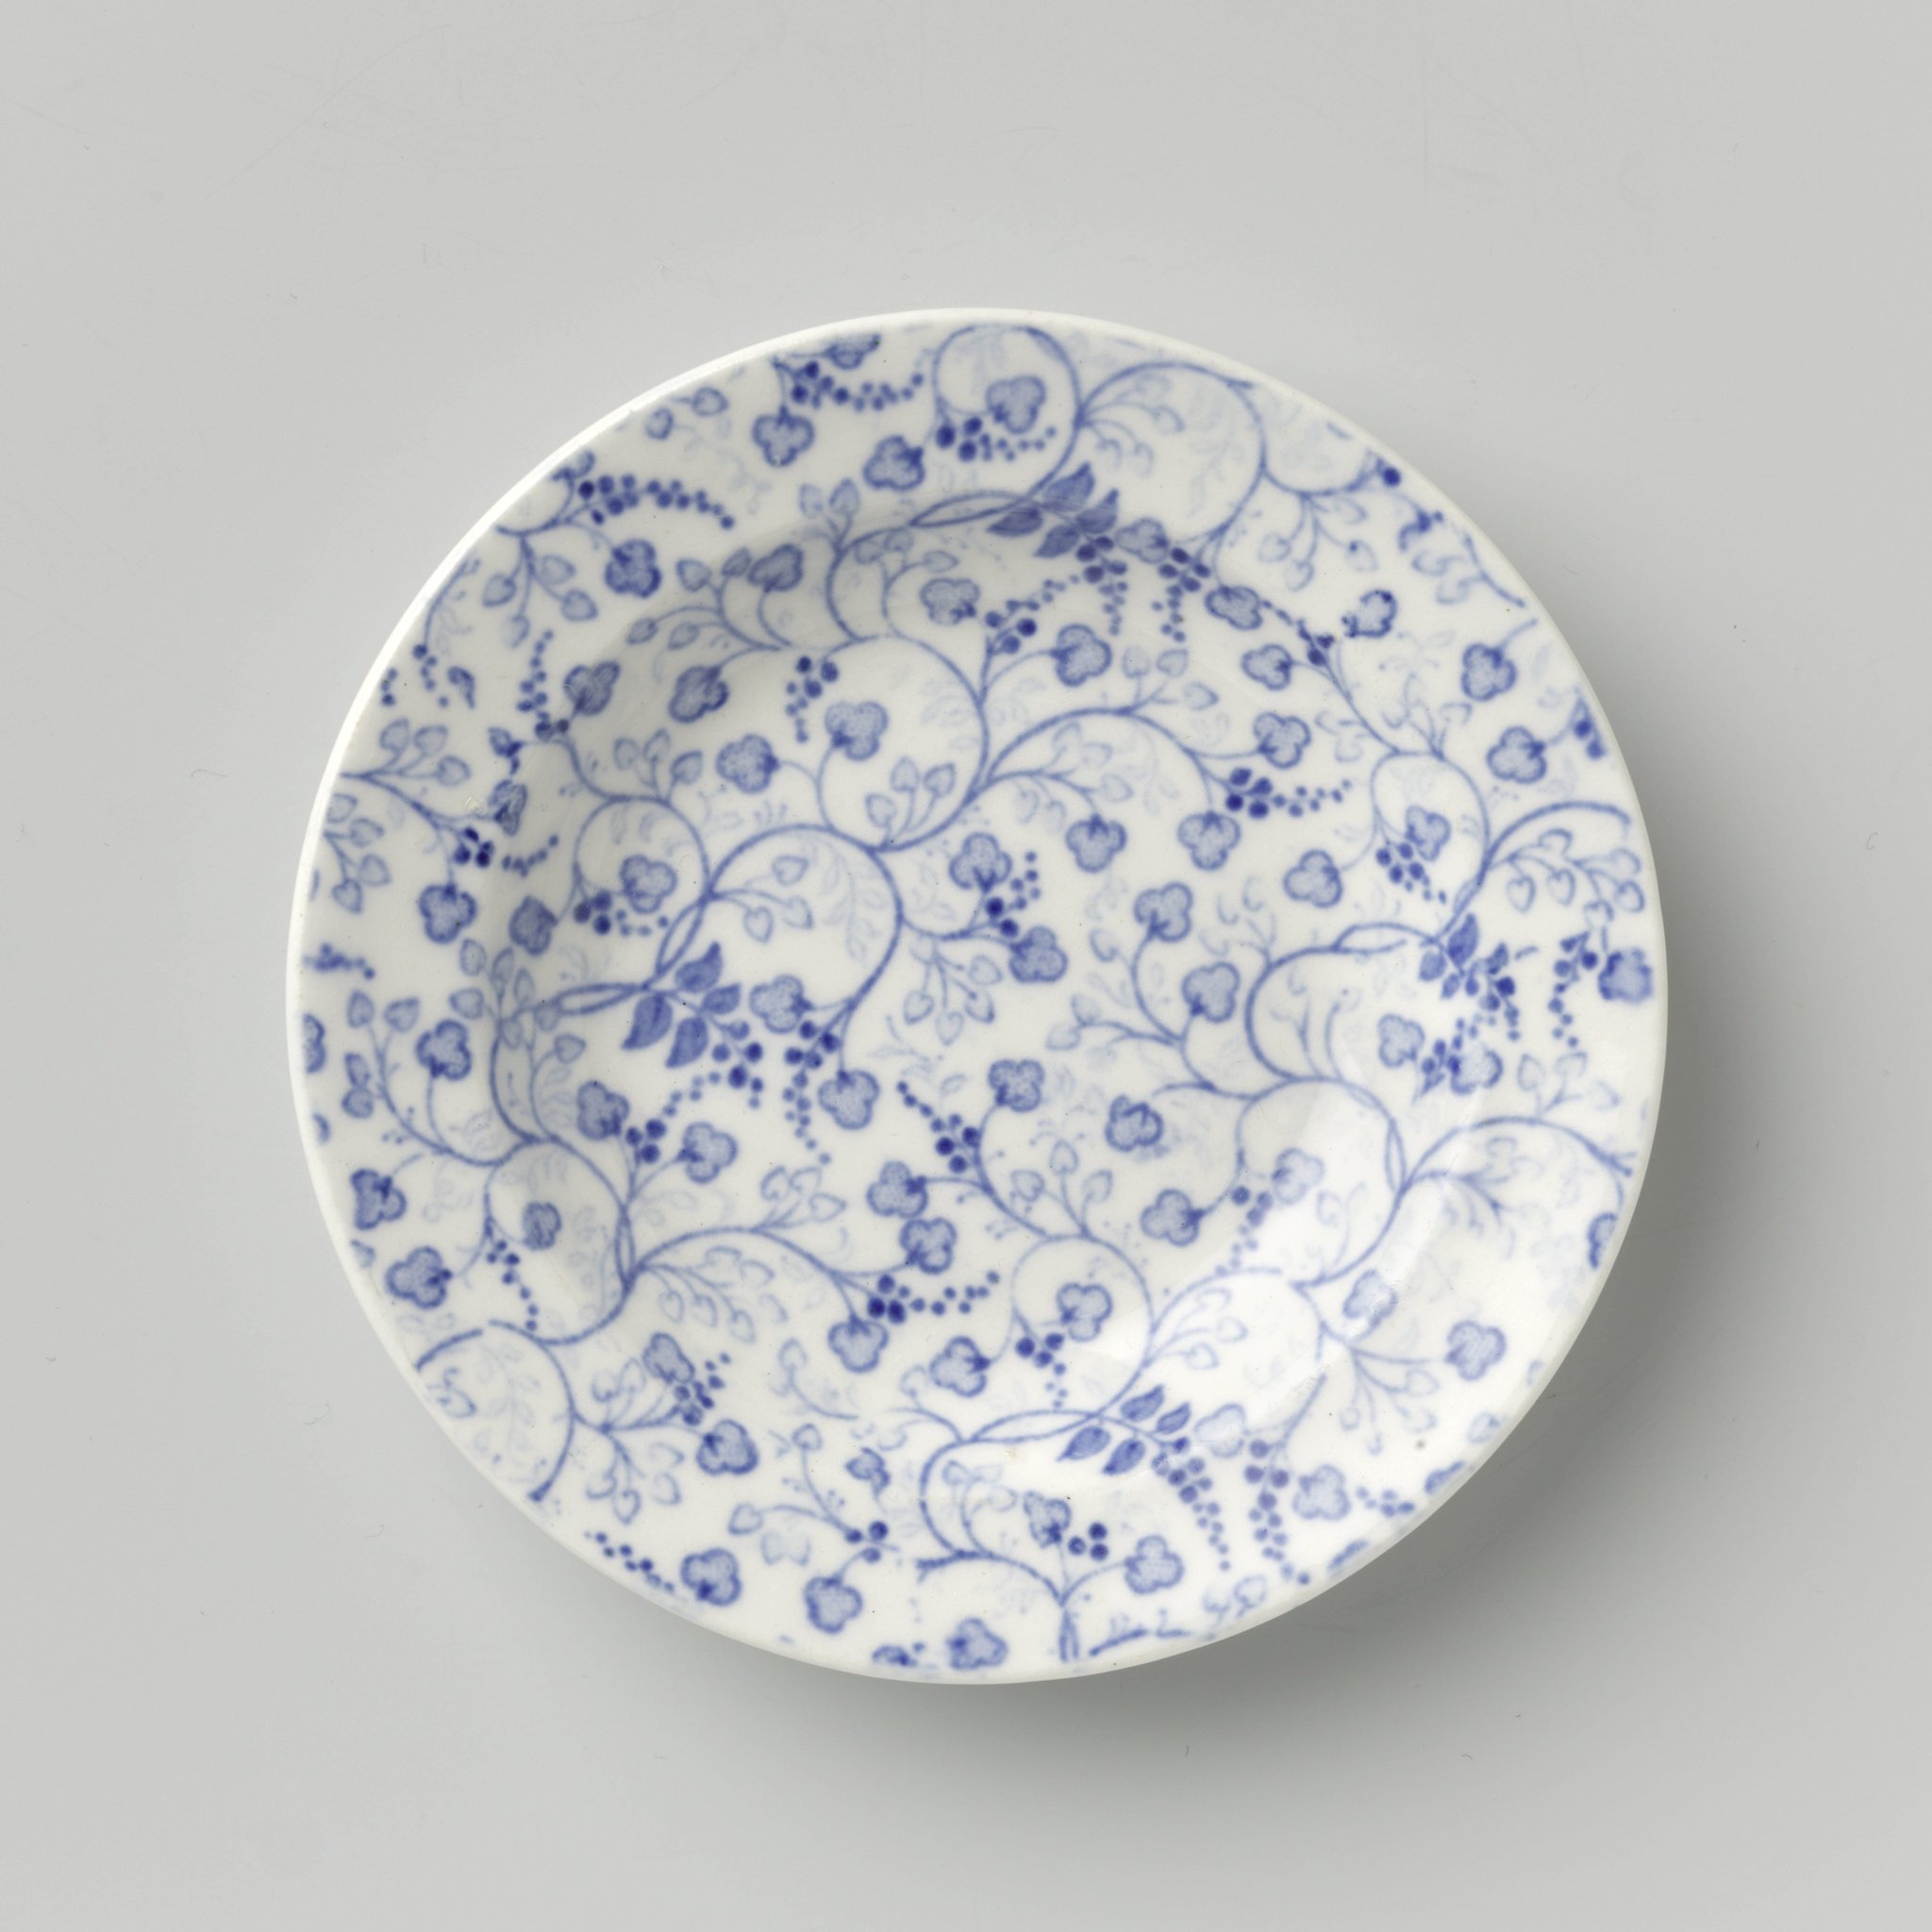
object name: plate dish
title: Bord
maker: petrus regout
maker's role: plateelbakker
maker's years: 1801-1879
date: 1867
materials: creamware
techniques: transfer decoration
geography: maastricht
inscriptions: mark: ‘PARSEME No 3’, check stamp: ‘PR’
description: Bord van aardewerk, met blauw doorlopend bloemendecor, behorend tot een kinderservies.